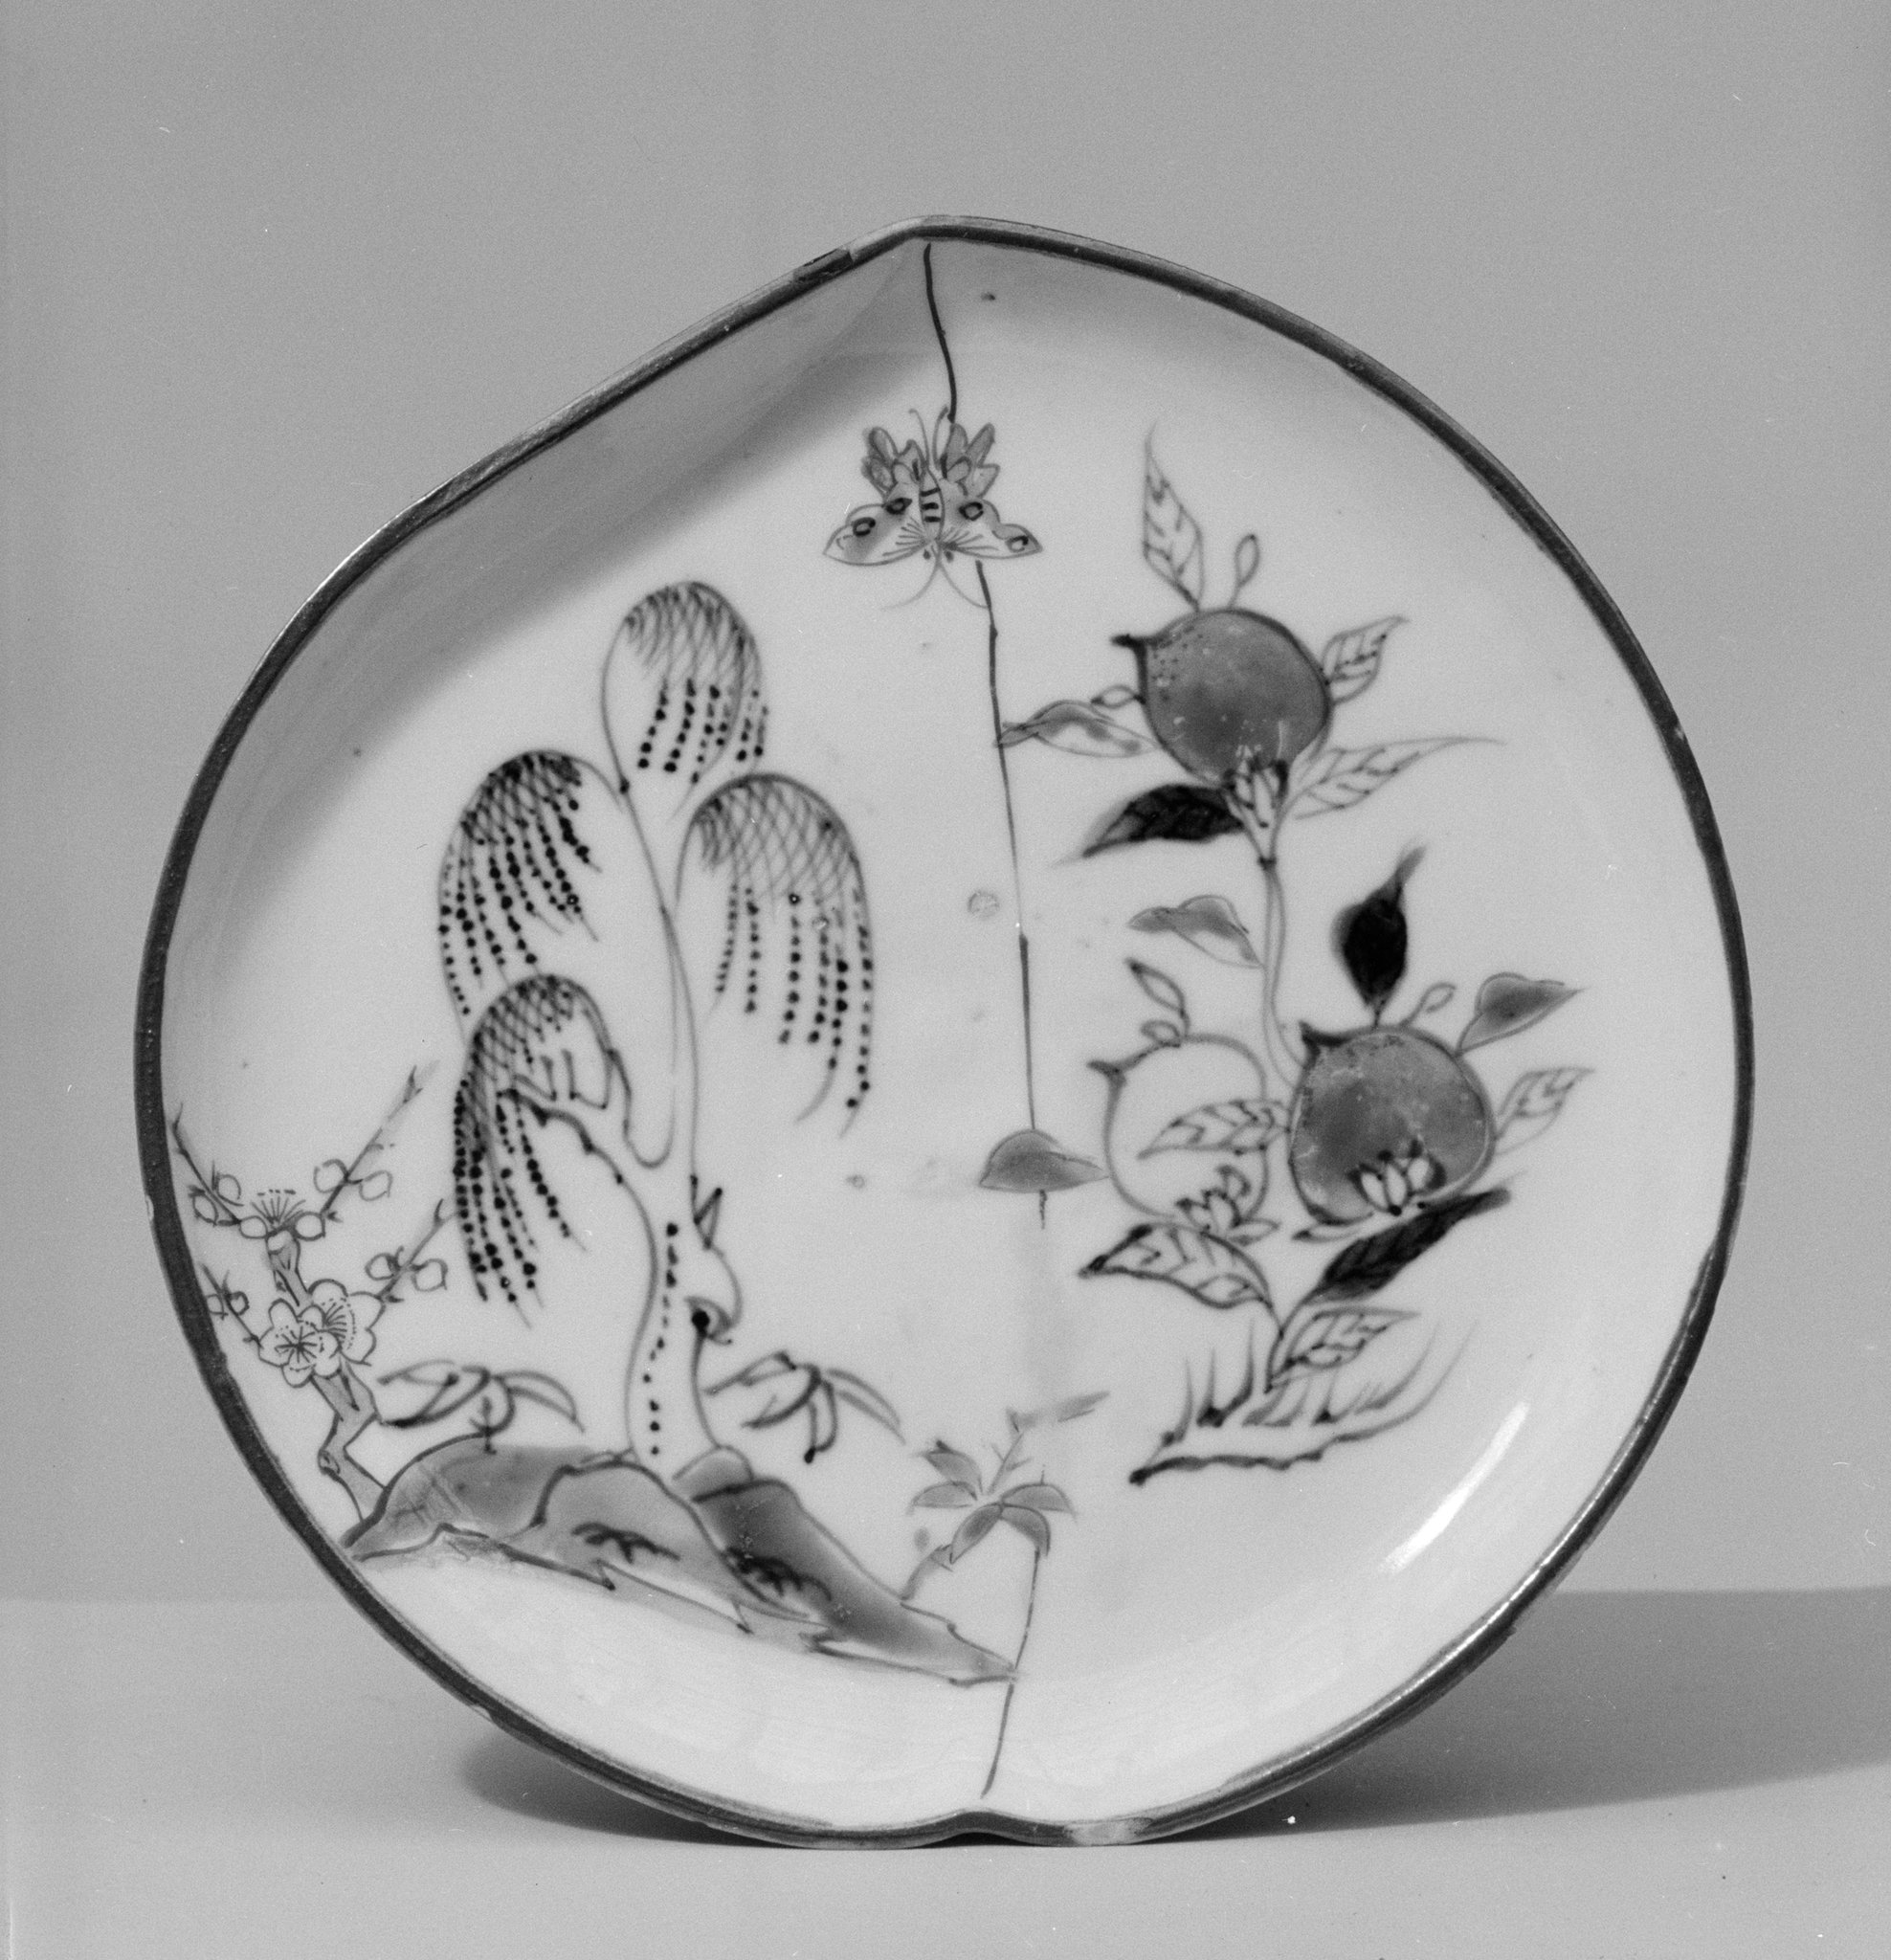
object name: dish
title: Peach-shaped dish with trees and peaches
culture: chinese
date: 1601-1650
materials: cobalt, enamel, porcelain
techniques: overglaze, painting, polychrome, underglaze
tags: fruit,butterflies